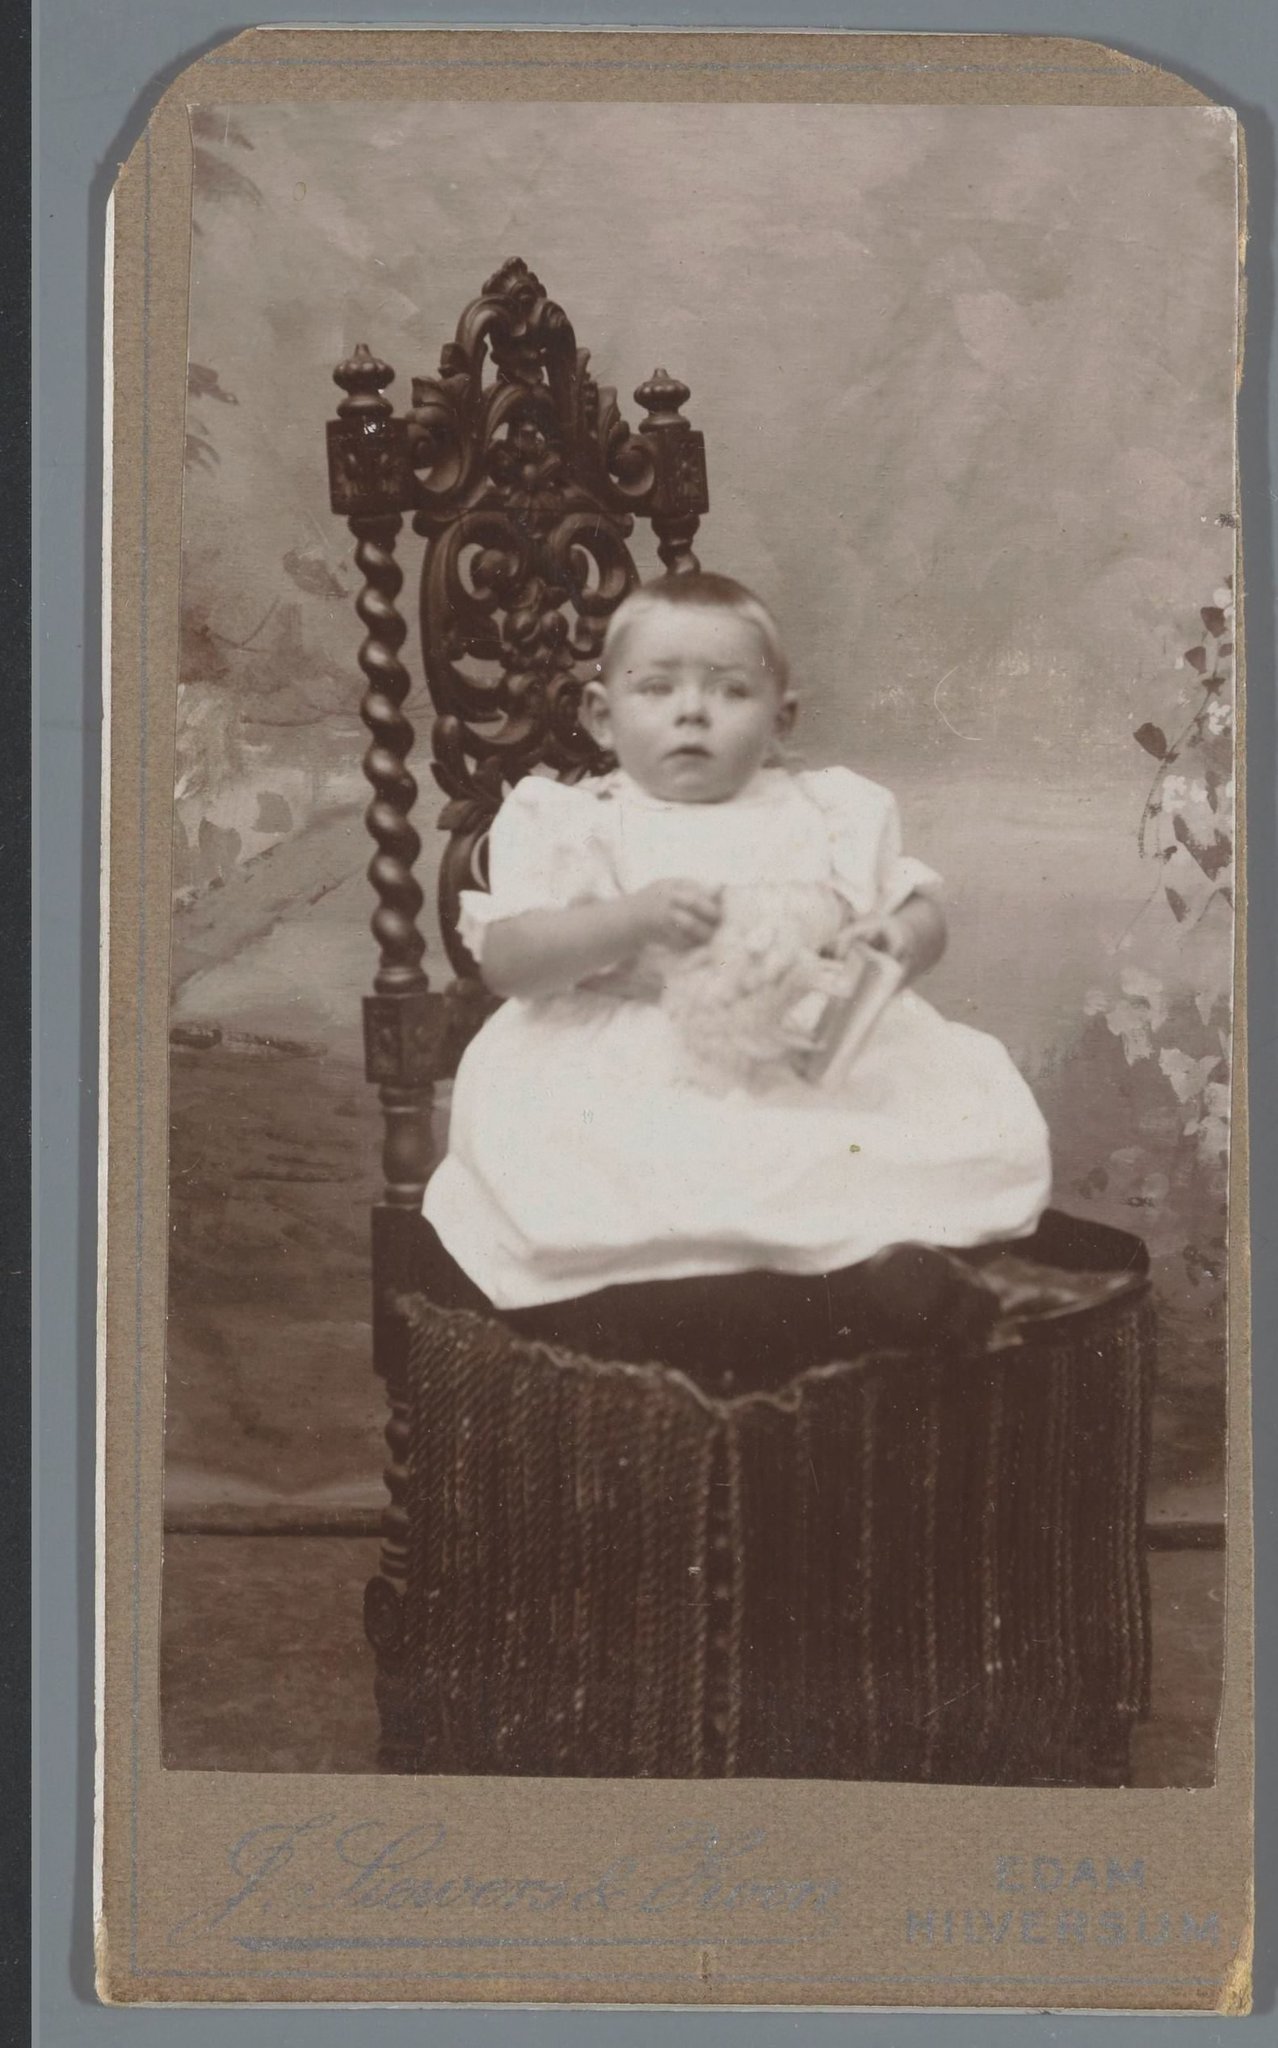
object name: photograph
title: Portret van een onbekende baby op een stoel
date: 1890-1918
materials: paper, cardboard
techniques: collodion silver print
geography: edam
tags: anonymous historical person portrayed, infant, baby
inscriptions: inscription: ‘Edam/ Hilversum./ Specialiteit in vergrootingen.’